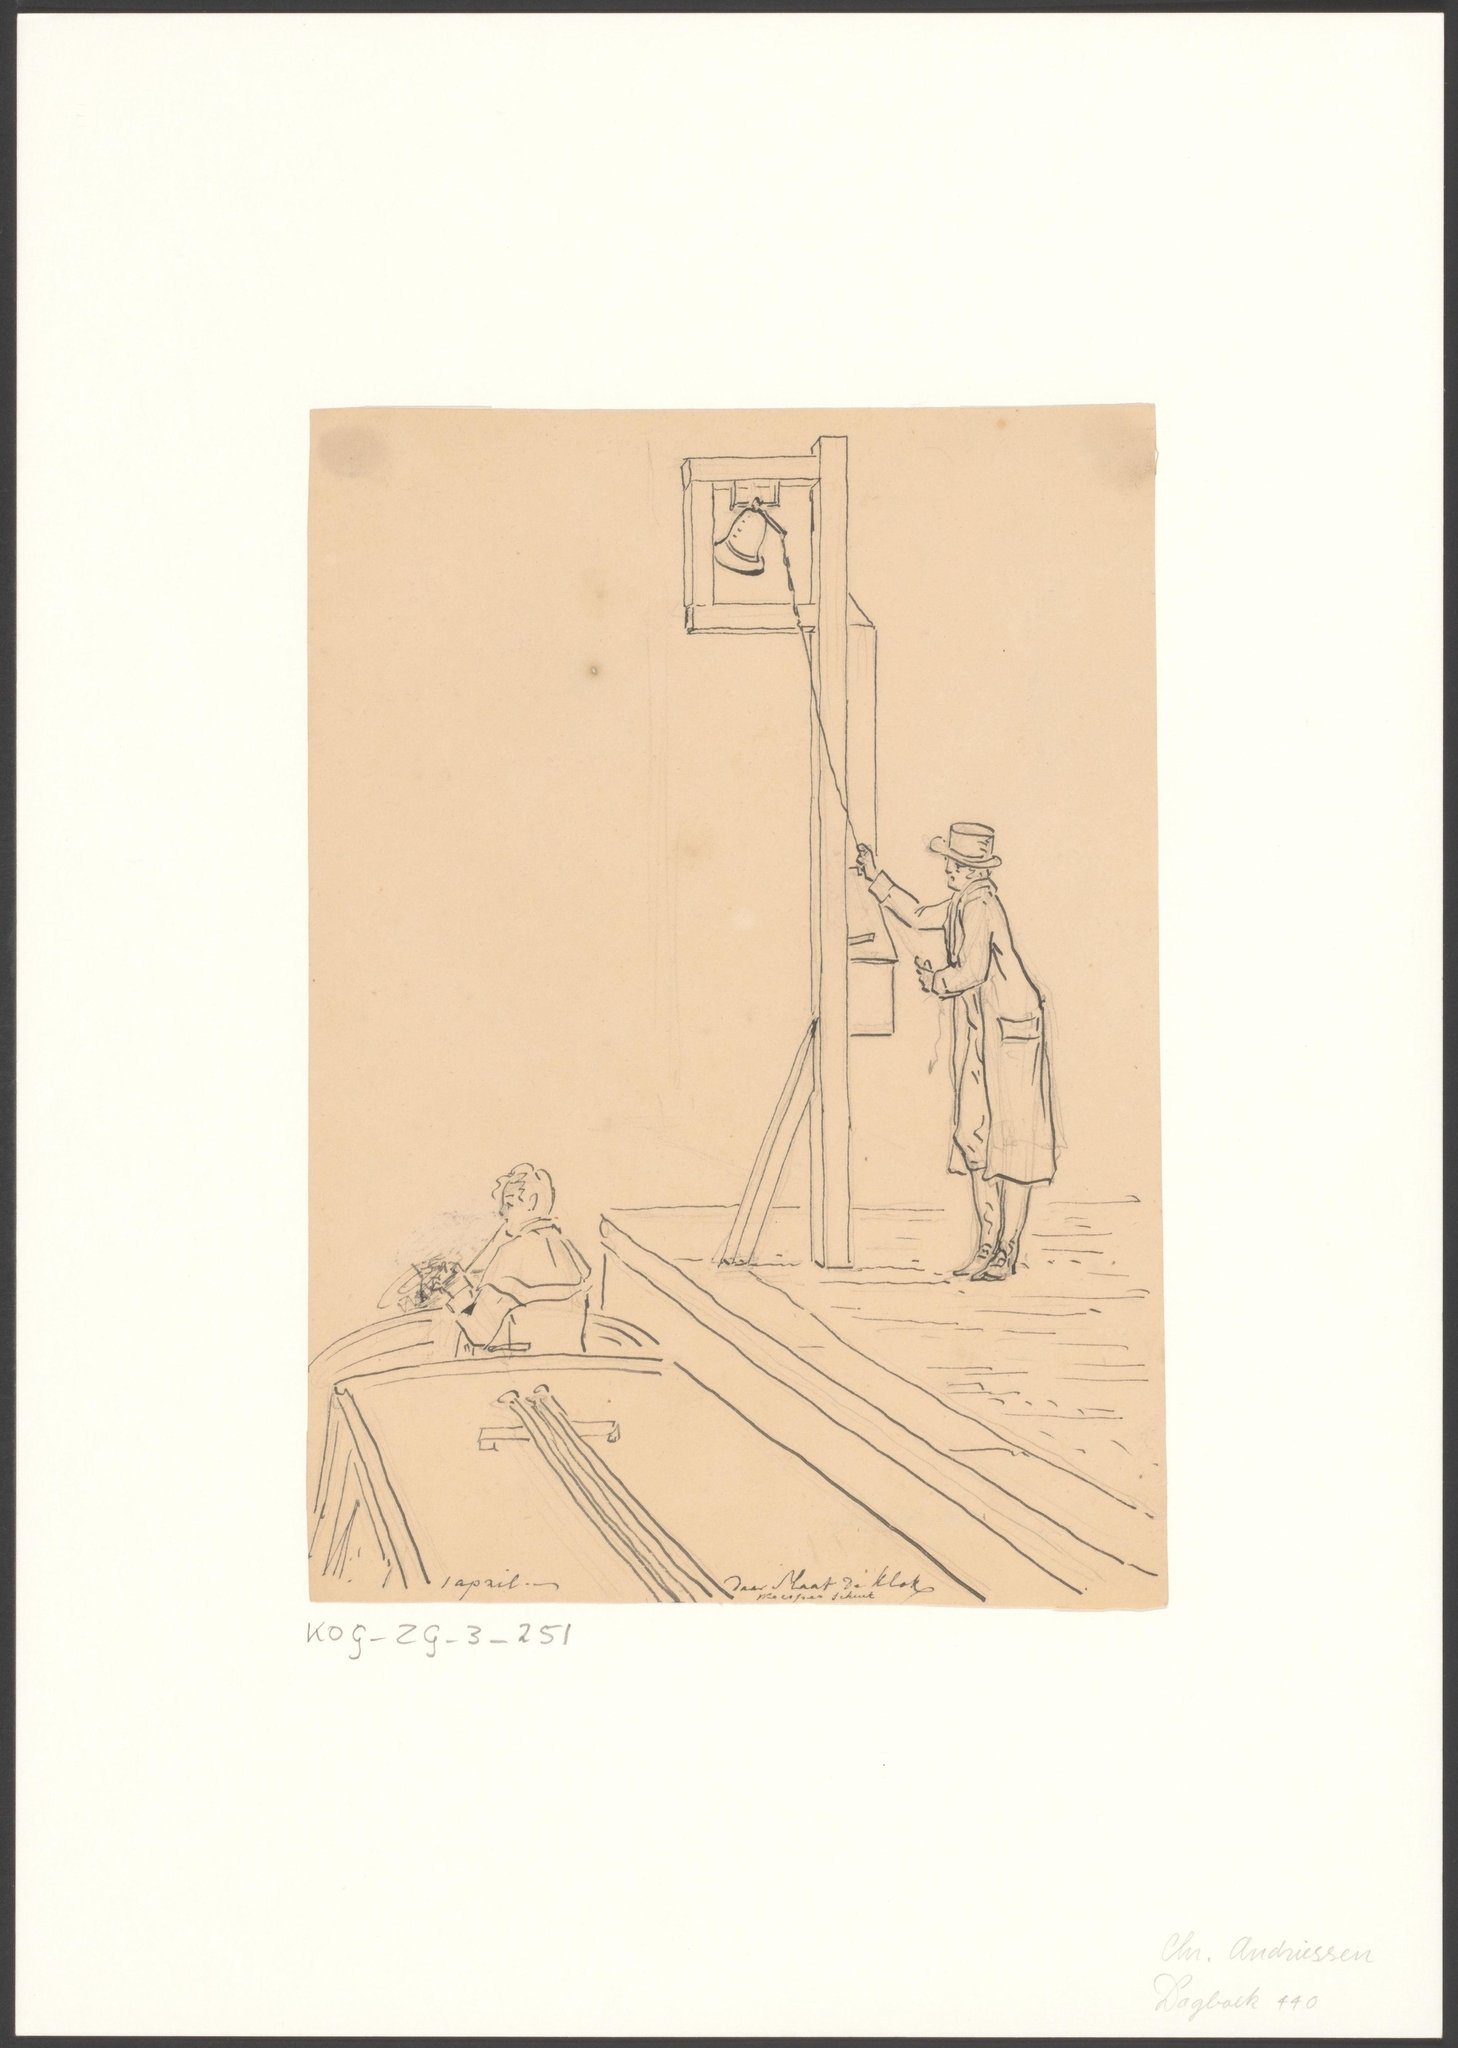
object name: drawing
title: Man luidt de bel voor de trekschuit naar Weesp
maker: christiaan andriessen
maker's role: draughtsman, print maker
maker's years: 1775-1846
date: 1805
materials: ink, paper, pencil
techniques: pen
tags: print maker, draughtsman, christiaan andriessen, tow-boat, towing-barge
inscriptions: inscription: ‘1 april daar slaat de klok’, signature: ‘J Andriessen’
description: De bel kondigt het vertrek aan van de trekschuit naar Weesp. De bel kondigt het vertrek aan van de trekschuit naar Weesp.